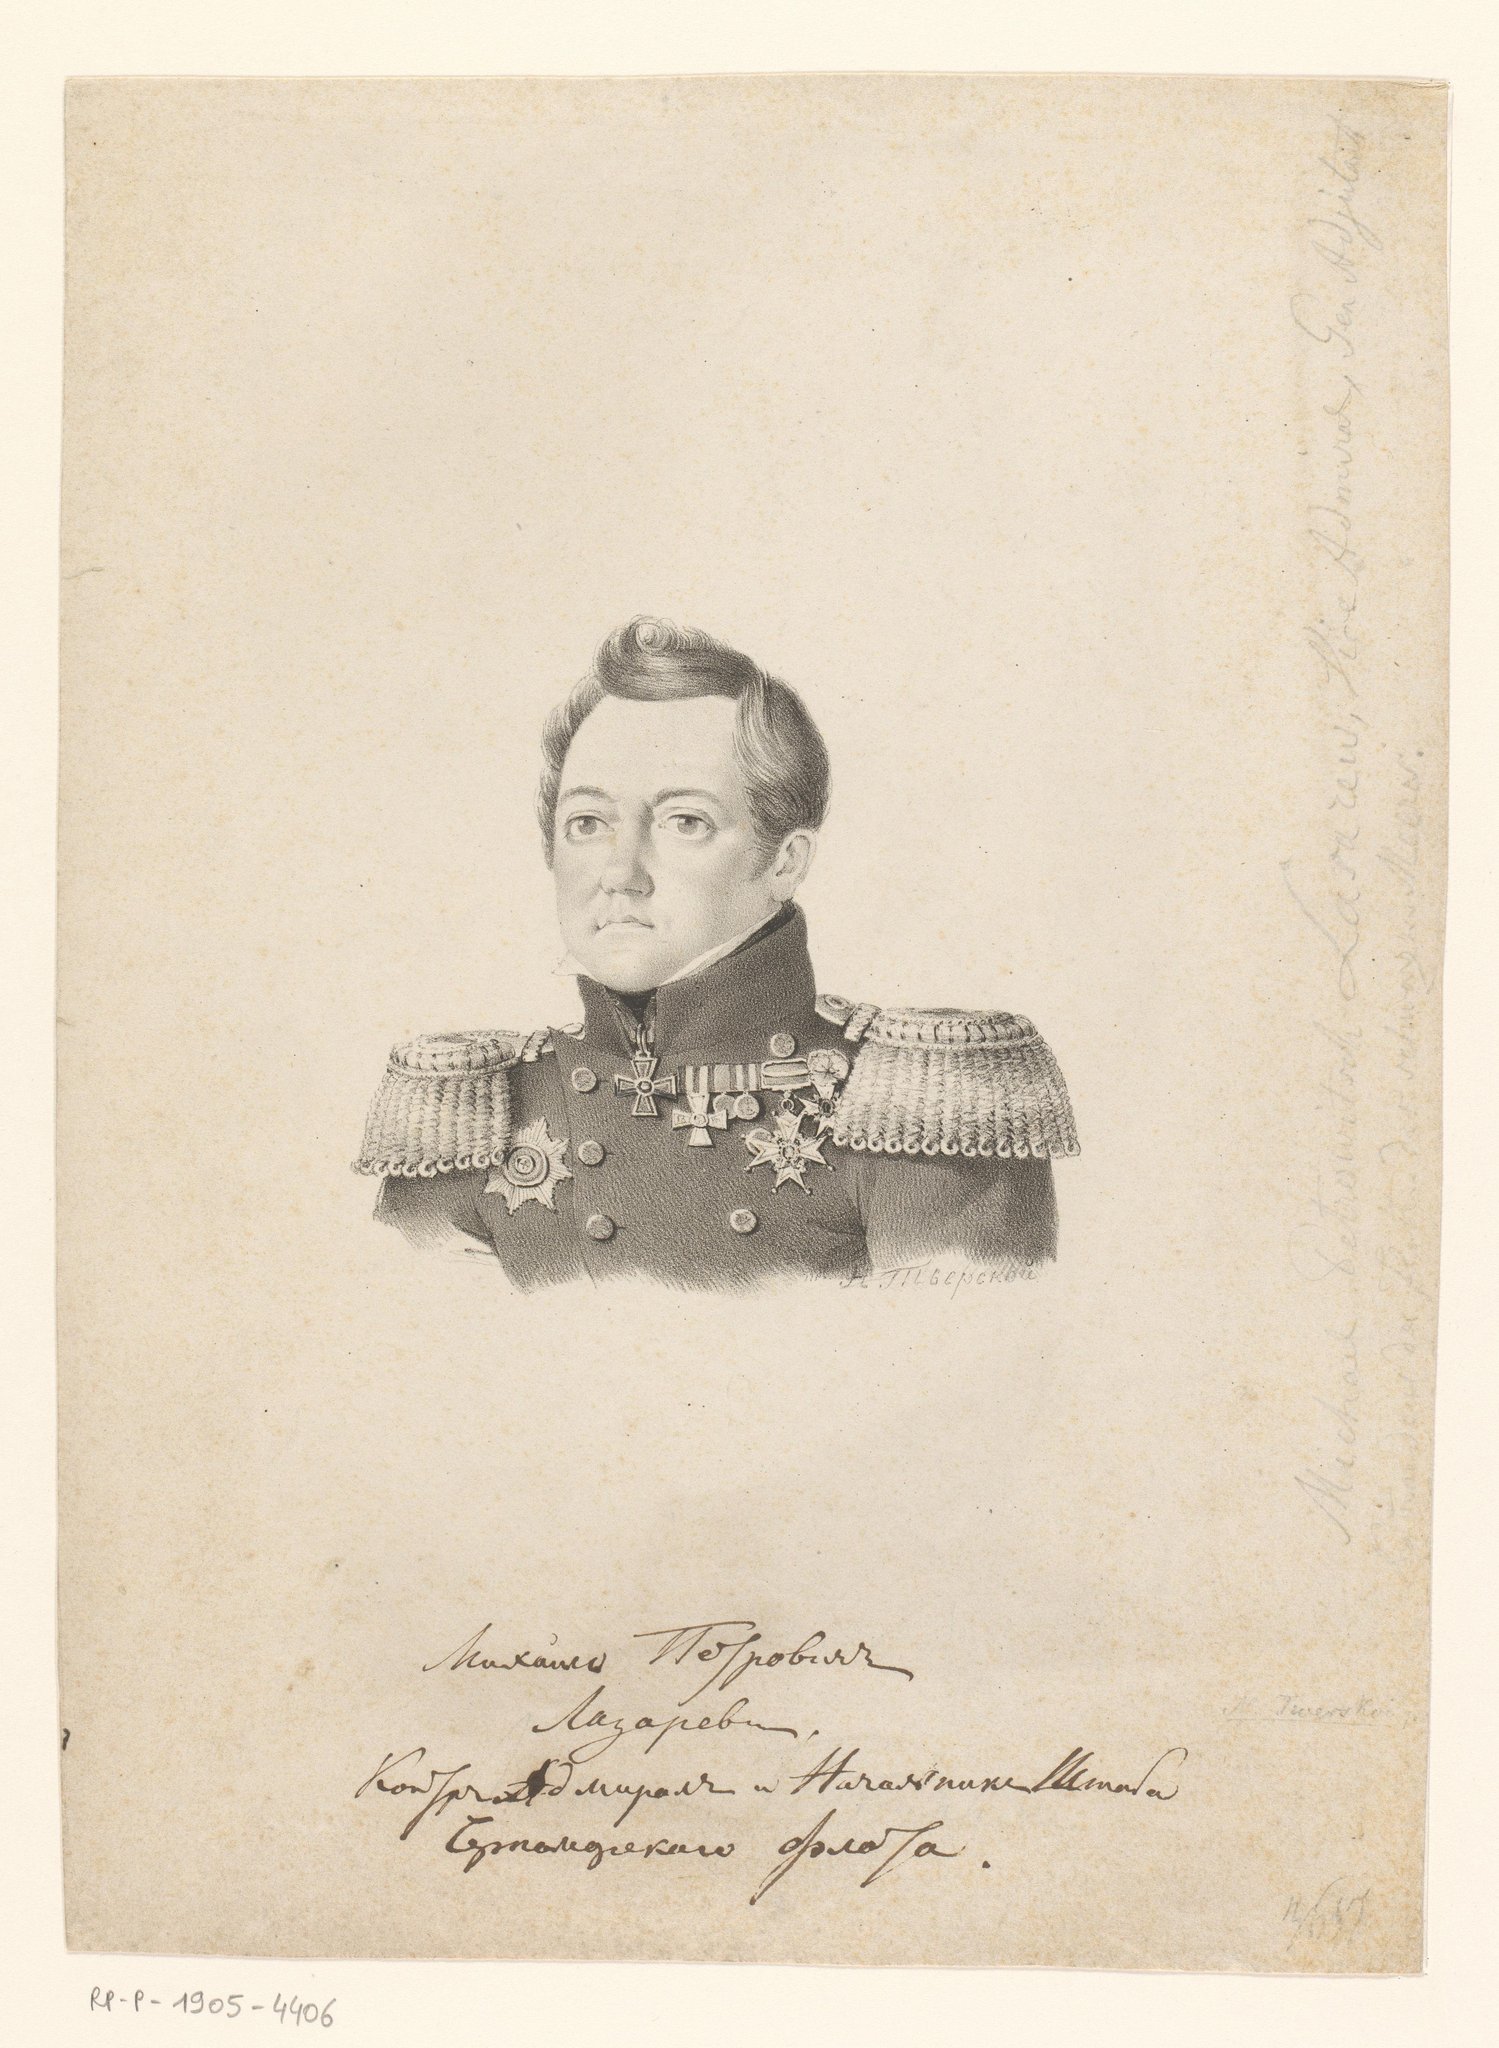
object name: print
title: Portret van een onbekende man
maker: Anonymous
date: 1820-1870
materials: paper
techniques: lithograph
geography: eastern europe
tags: adult man, historical persons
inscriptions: collector's mark: Lugt 2228, inscription